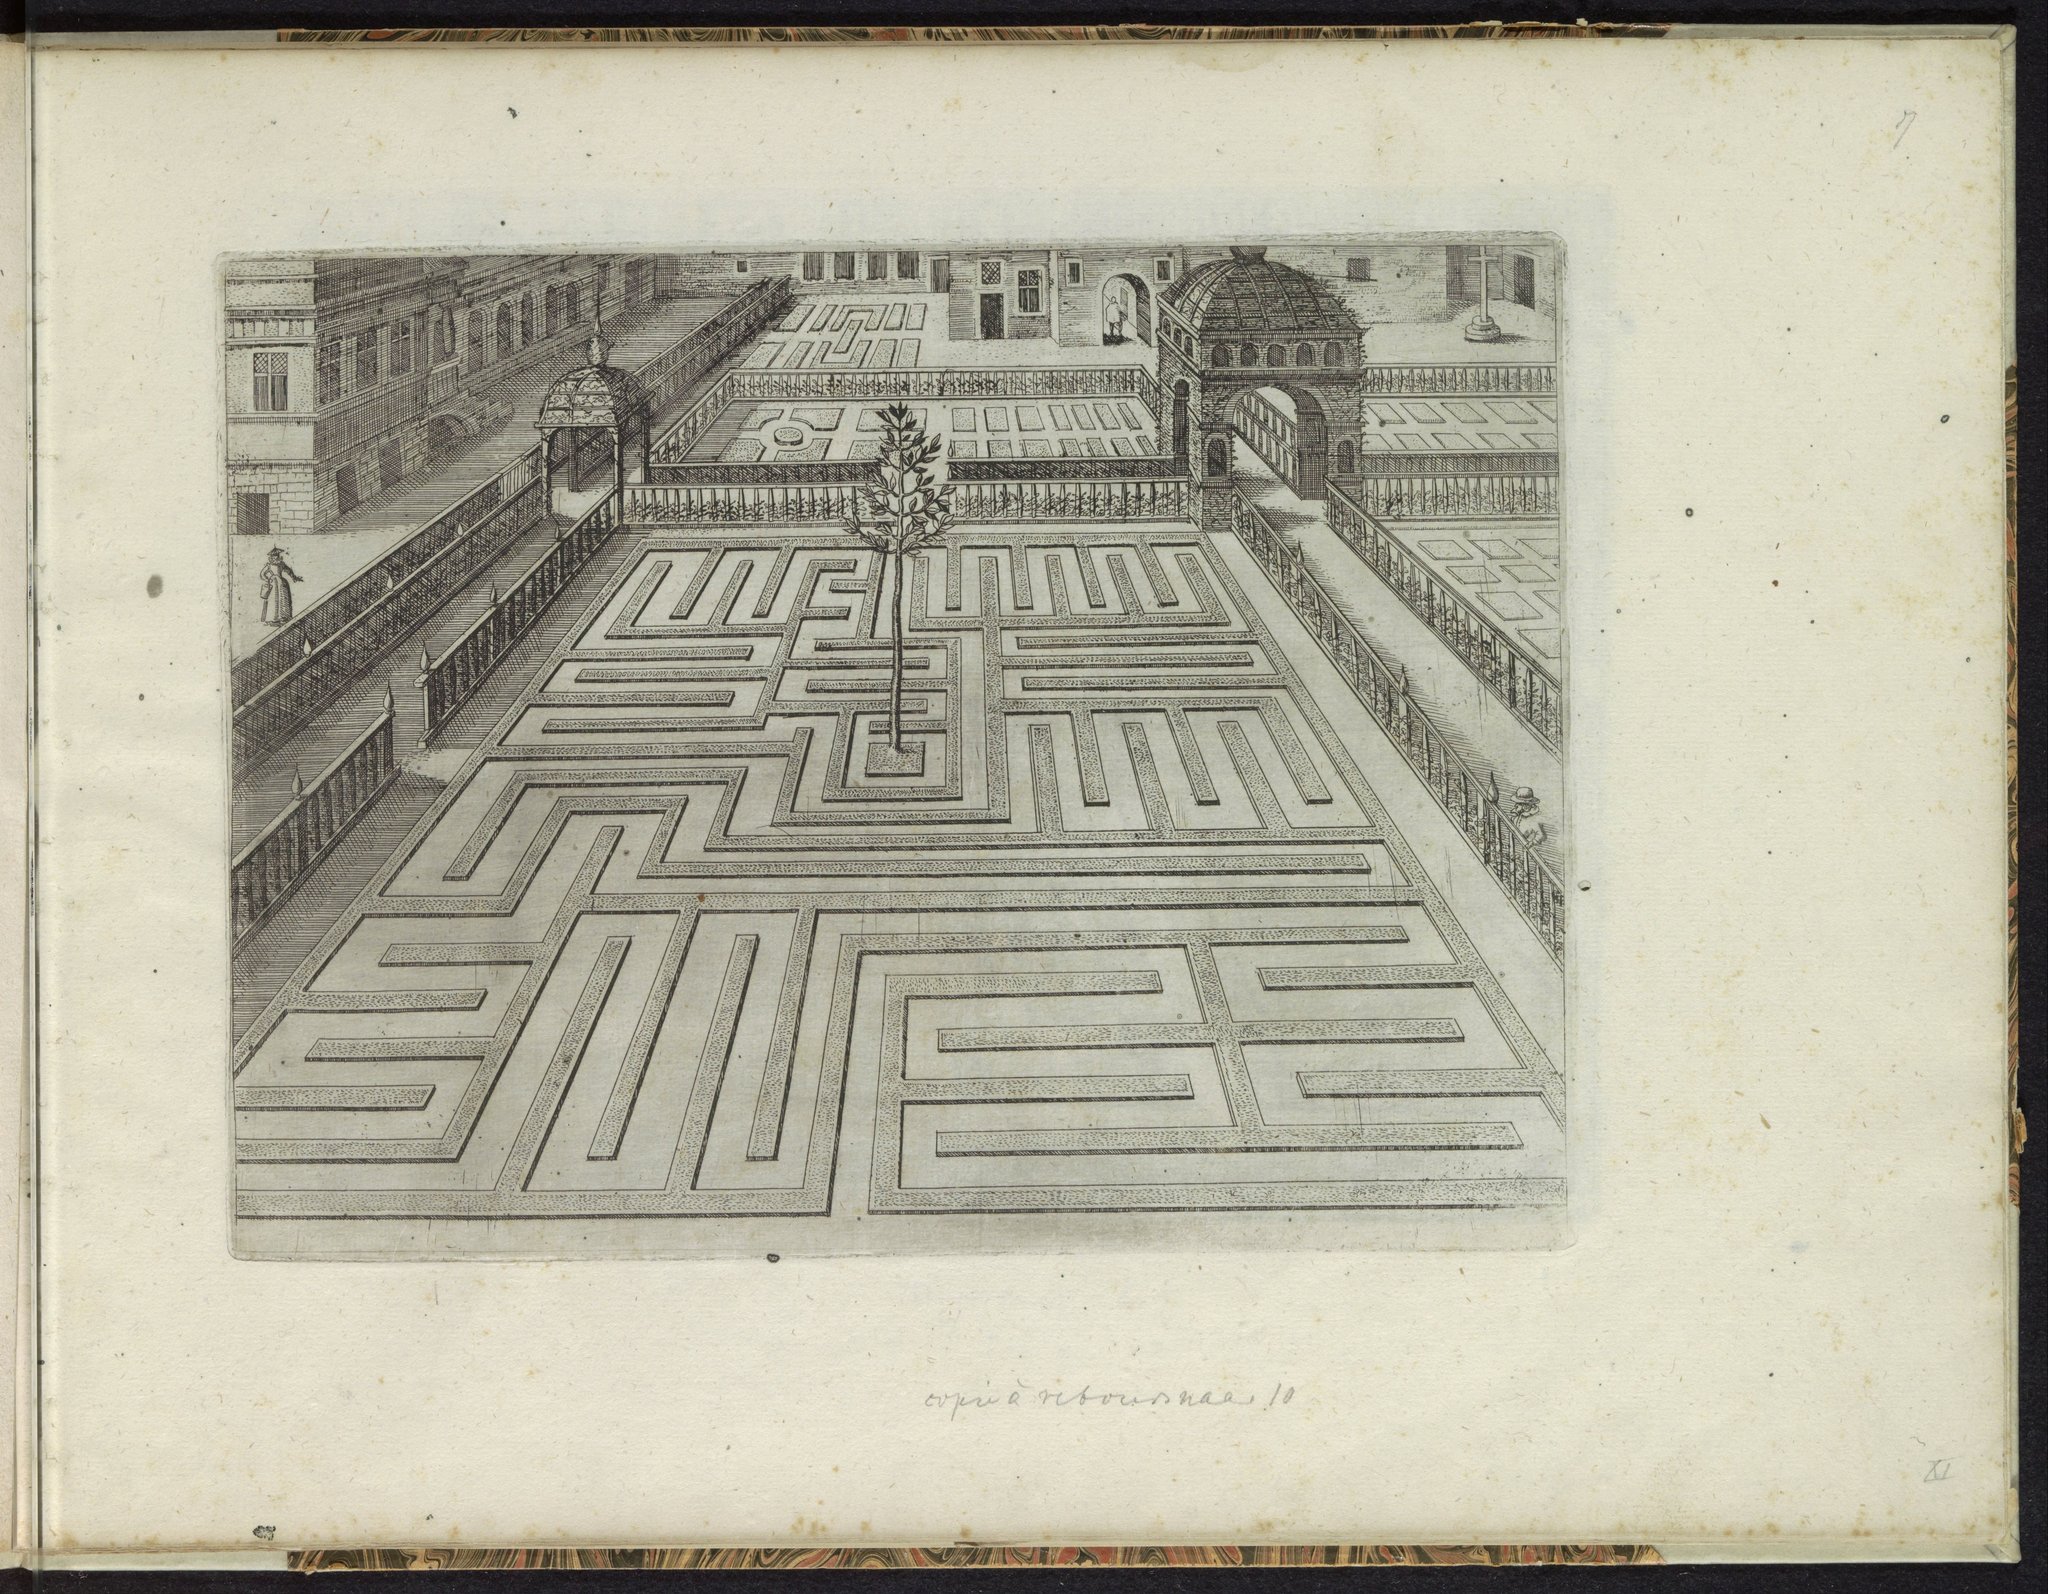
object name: album leaf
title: Tuinontwerpen geassocieerd met de Dorische, Ionische en Korinthische bouworden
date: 1615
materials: paper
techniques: etching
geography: cologne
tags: garden, french or architectonic garden; formal garden, labyrinth, maze ~ garden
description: Op de voorgrond staat een hoge boom in het midden van een rechthoekige parterre, omgeven door een balustrade. In het midden staat een boom. Links loopt een vrouw met een mand. De tuin is aangelegd volgens de Korinthische bouworde. De prent maakt deel uit van een album.